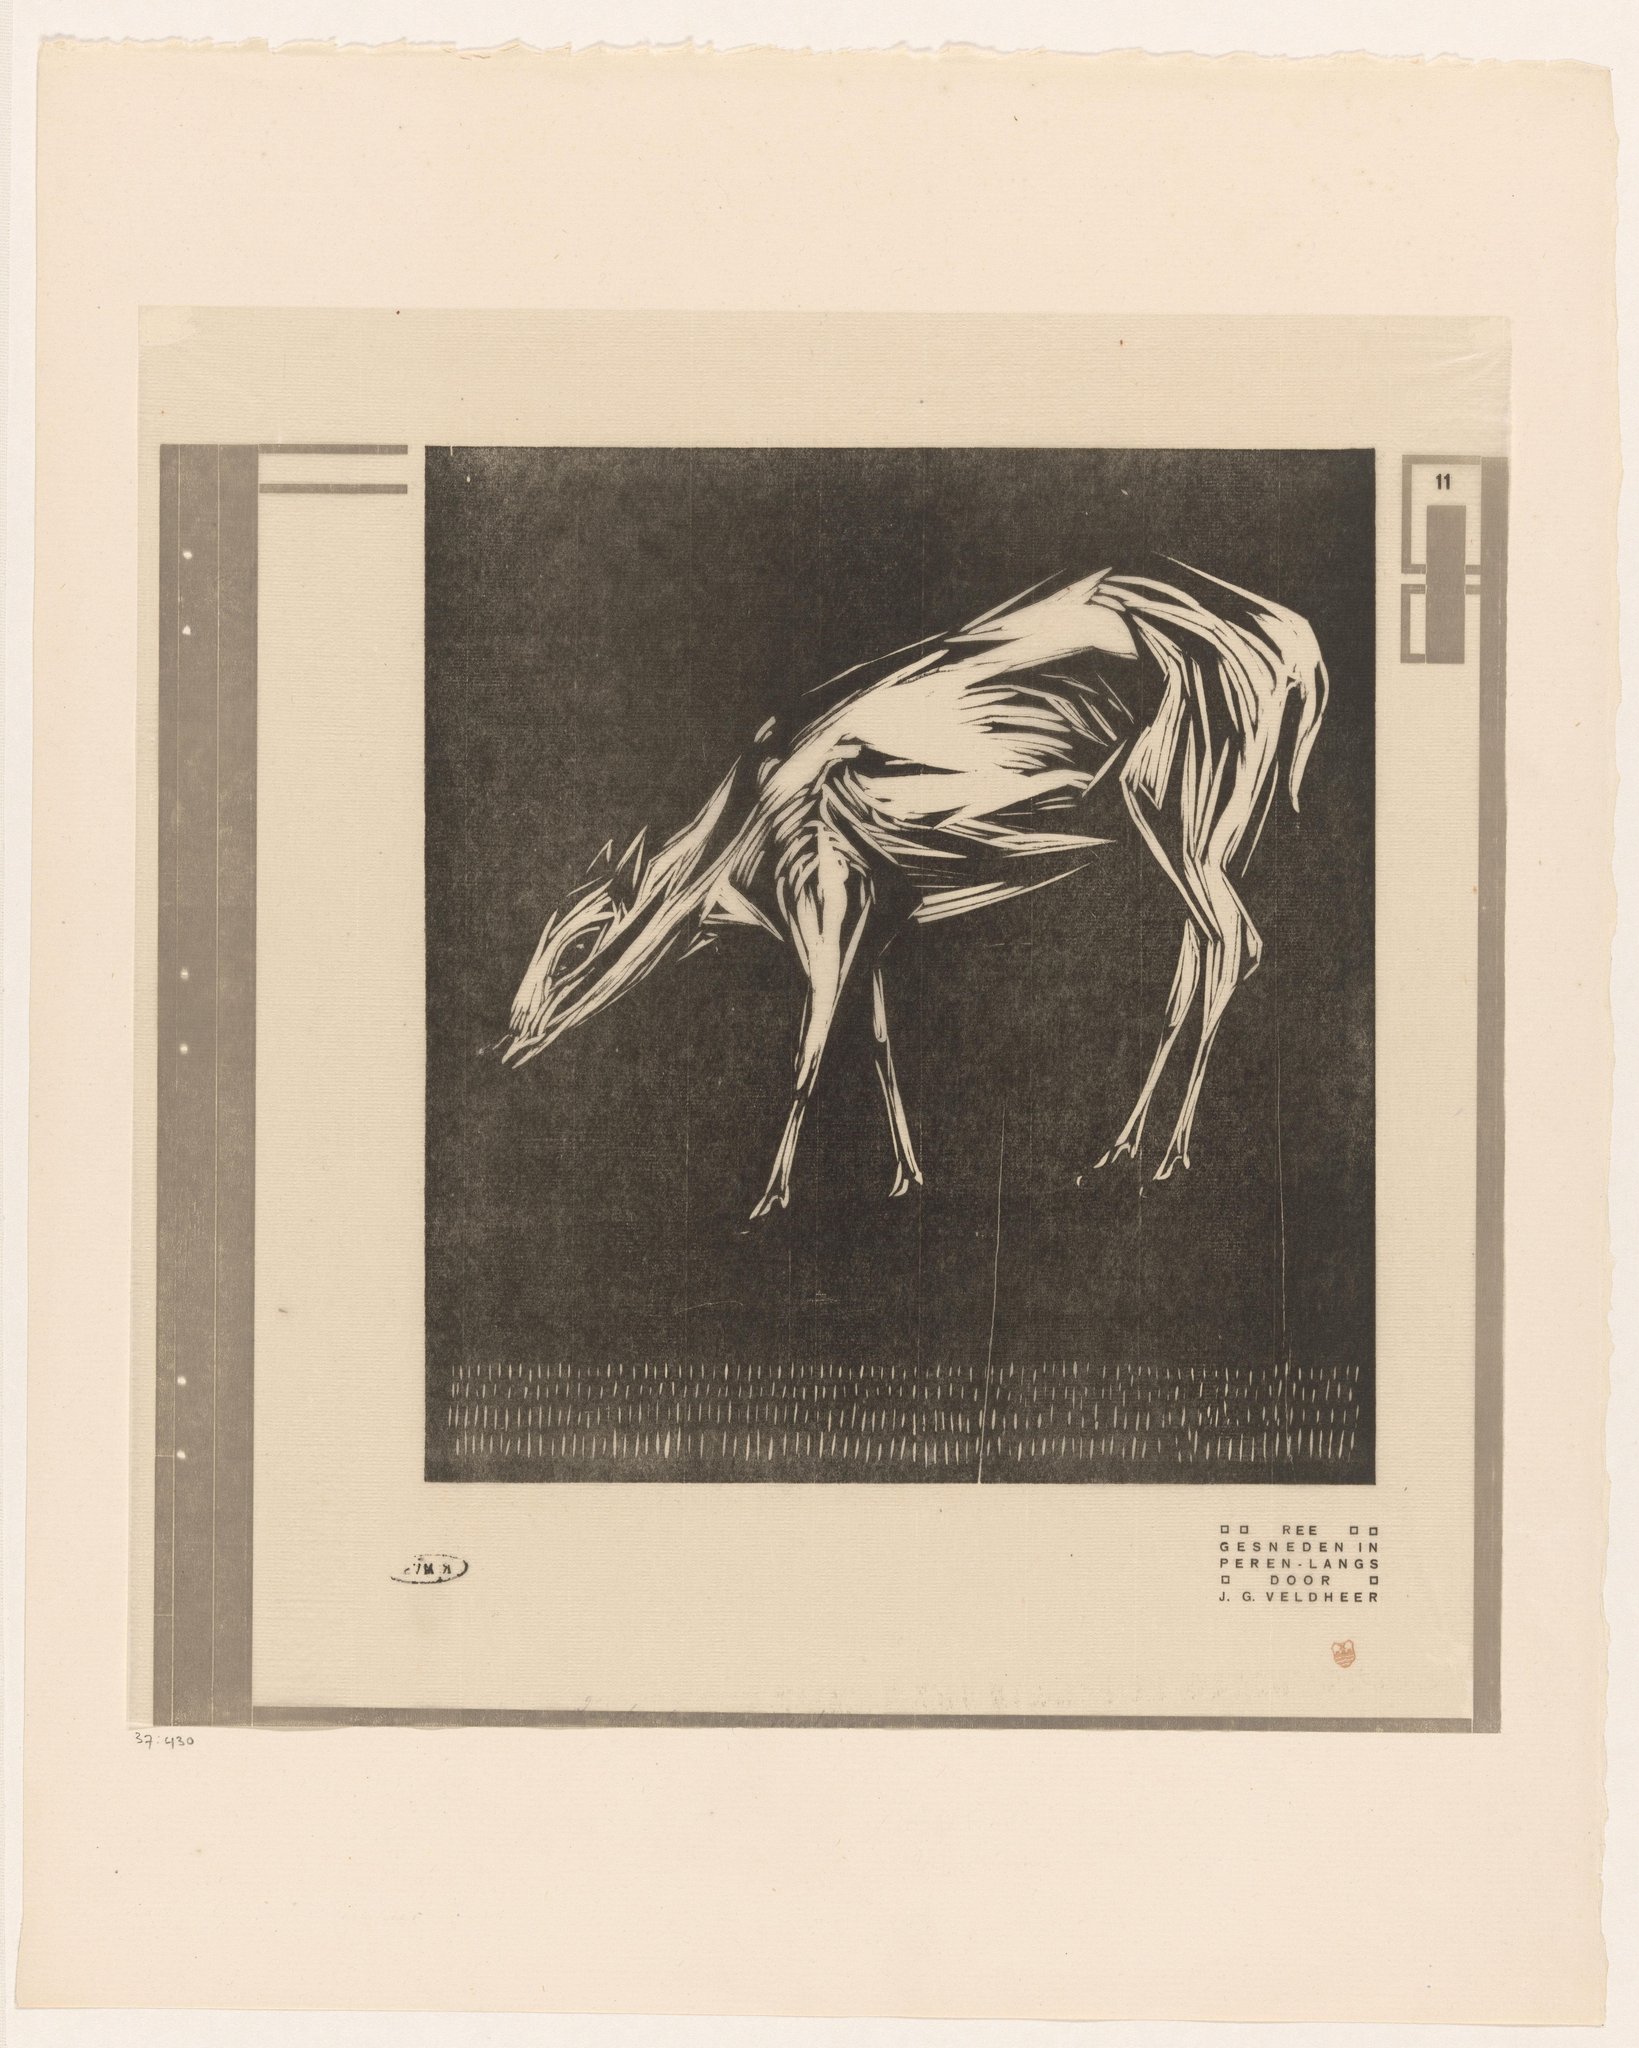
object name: print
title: Ree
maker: jacobus gerardus veldheer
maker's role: draughtsman, print maker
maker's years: 1866-1954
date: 1876-1937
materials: paper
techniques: woodcut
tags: hoofed animals: deer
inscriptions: annotation: ‘Ree/ gesneden in/ peren-langs/ door/ J.G. Veldheer’, collector's mark: Lugt 2760, collector's mark: Lugt 2228